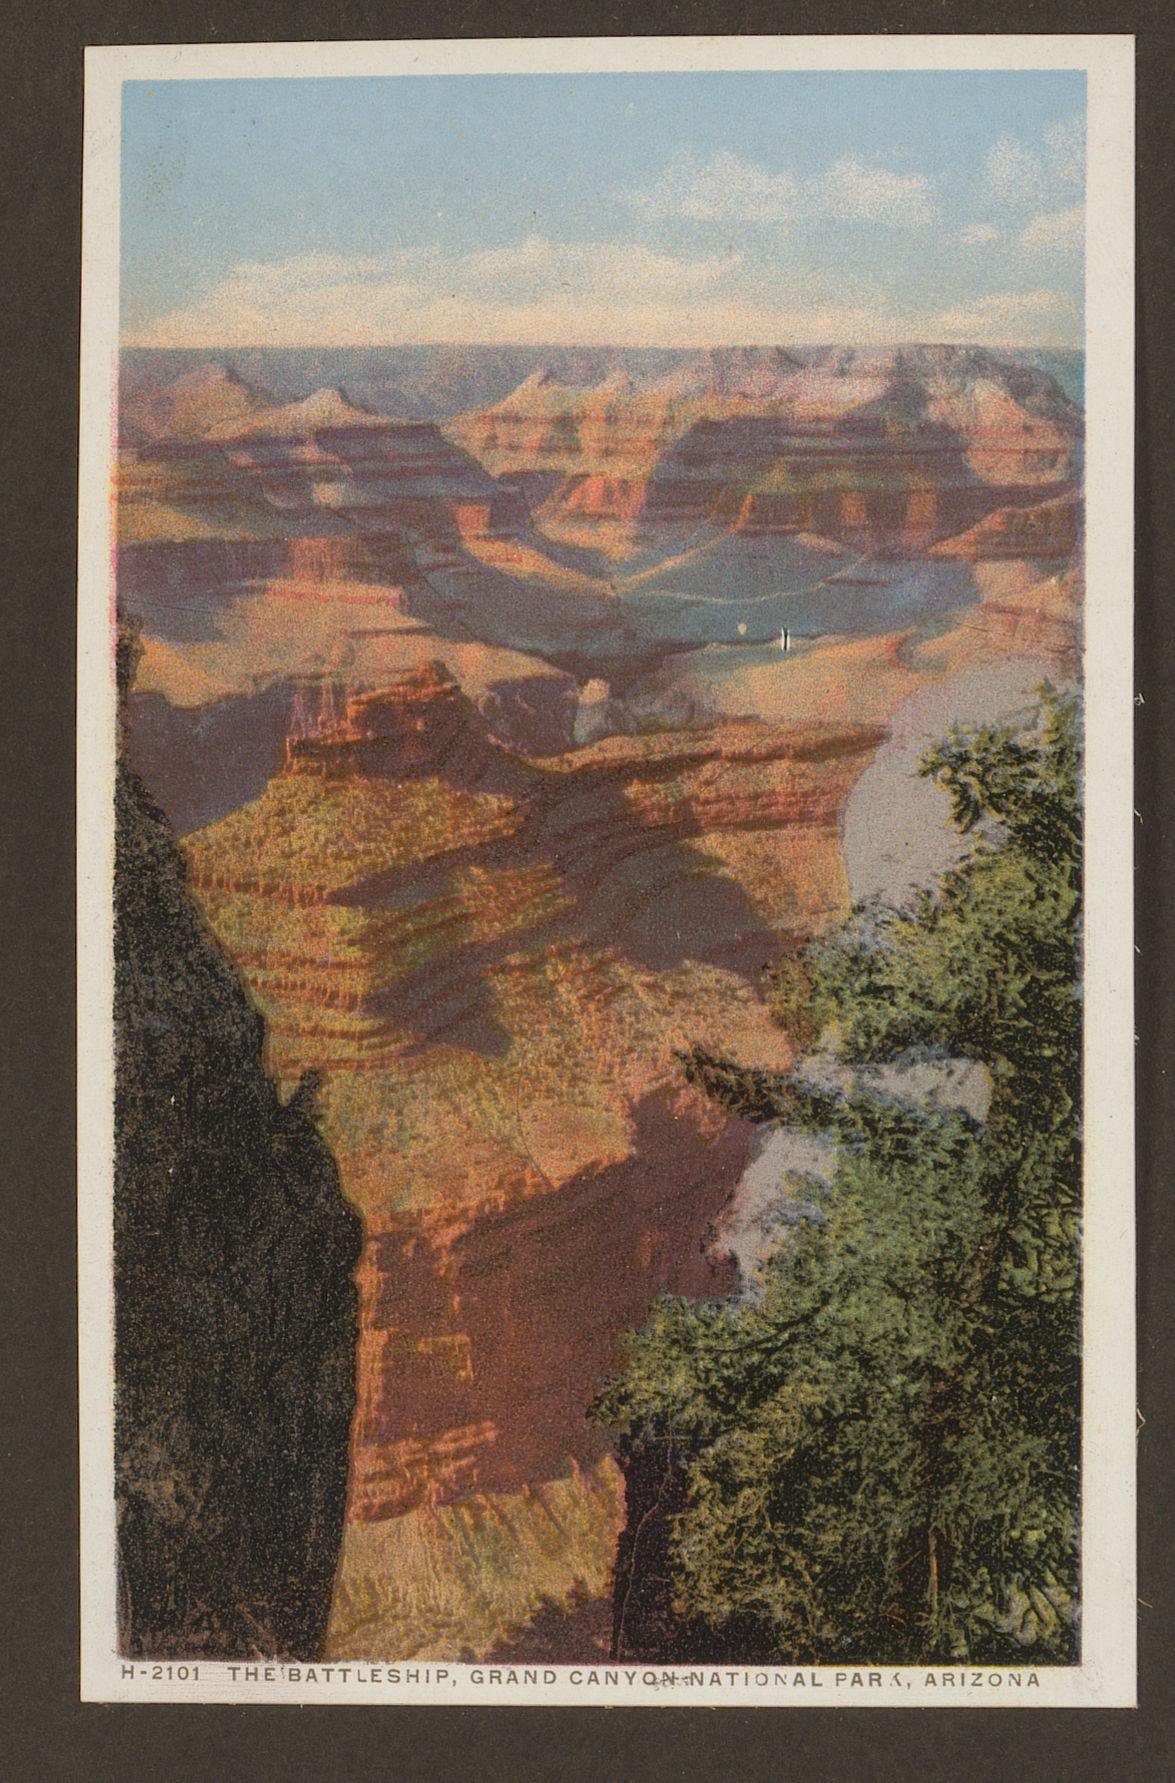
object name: photomechanical print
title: The battleship, Grand Canyon National Park, Arizona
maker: Anonymous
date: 1928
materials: paper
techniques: chromolithography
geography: grand canyon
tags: shop, store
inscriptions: number: ‘H-2101’, annotation: ‘Grand Canyon’